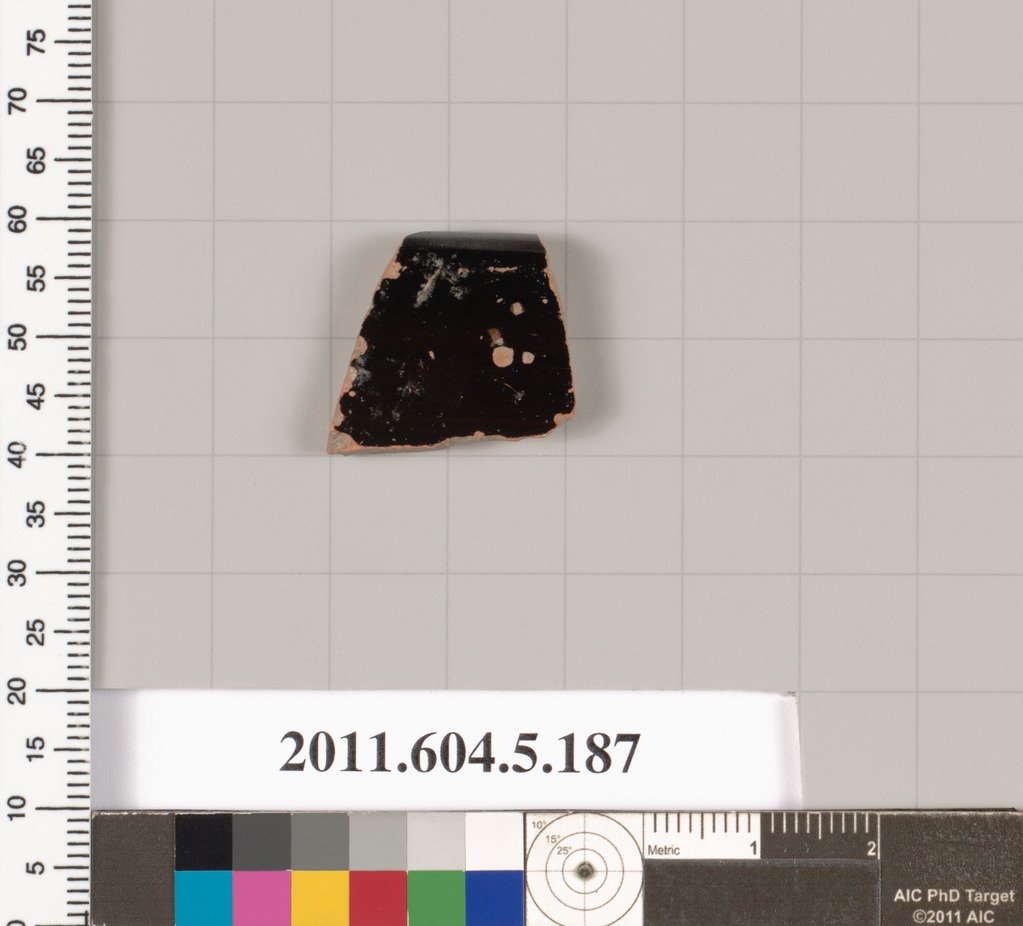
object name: kylix fragment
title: Terracotta rim fragment of a kylix (drinking cup)?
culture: greek, attic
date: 600-401 BCE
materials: terracotta